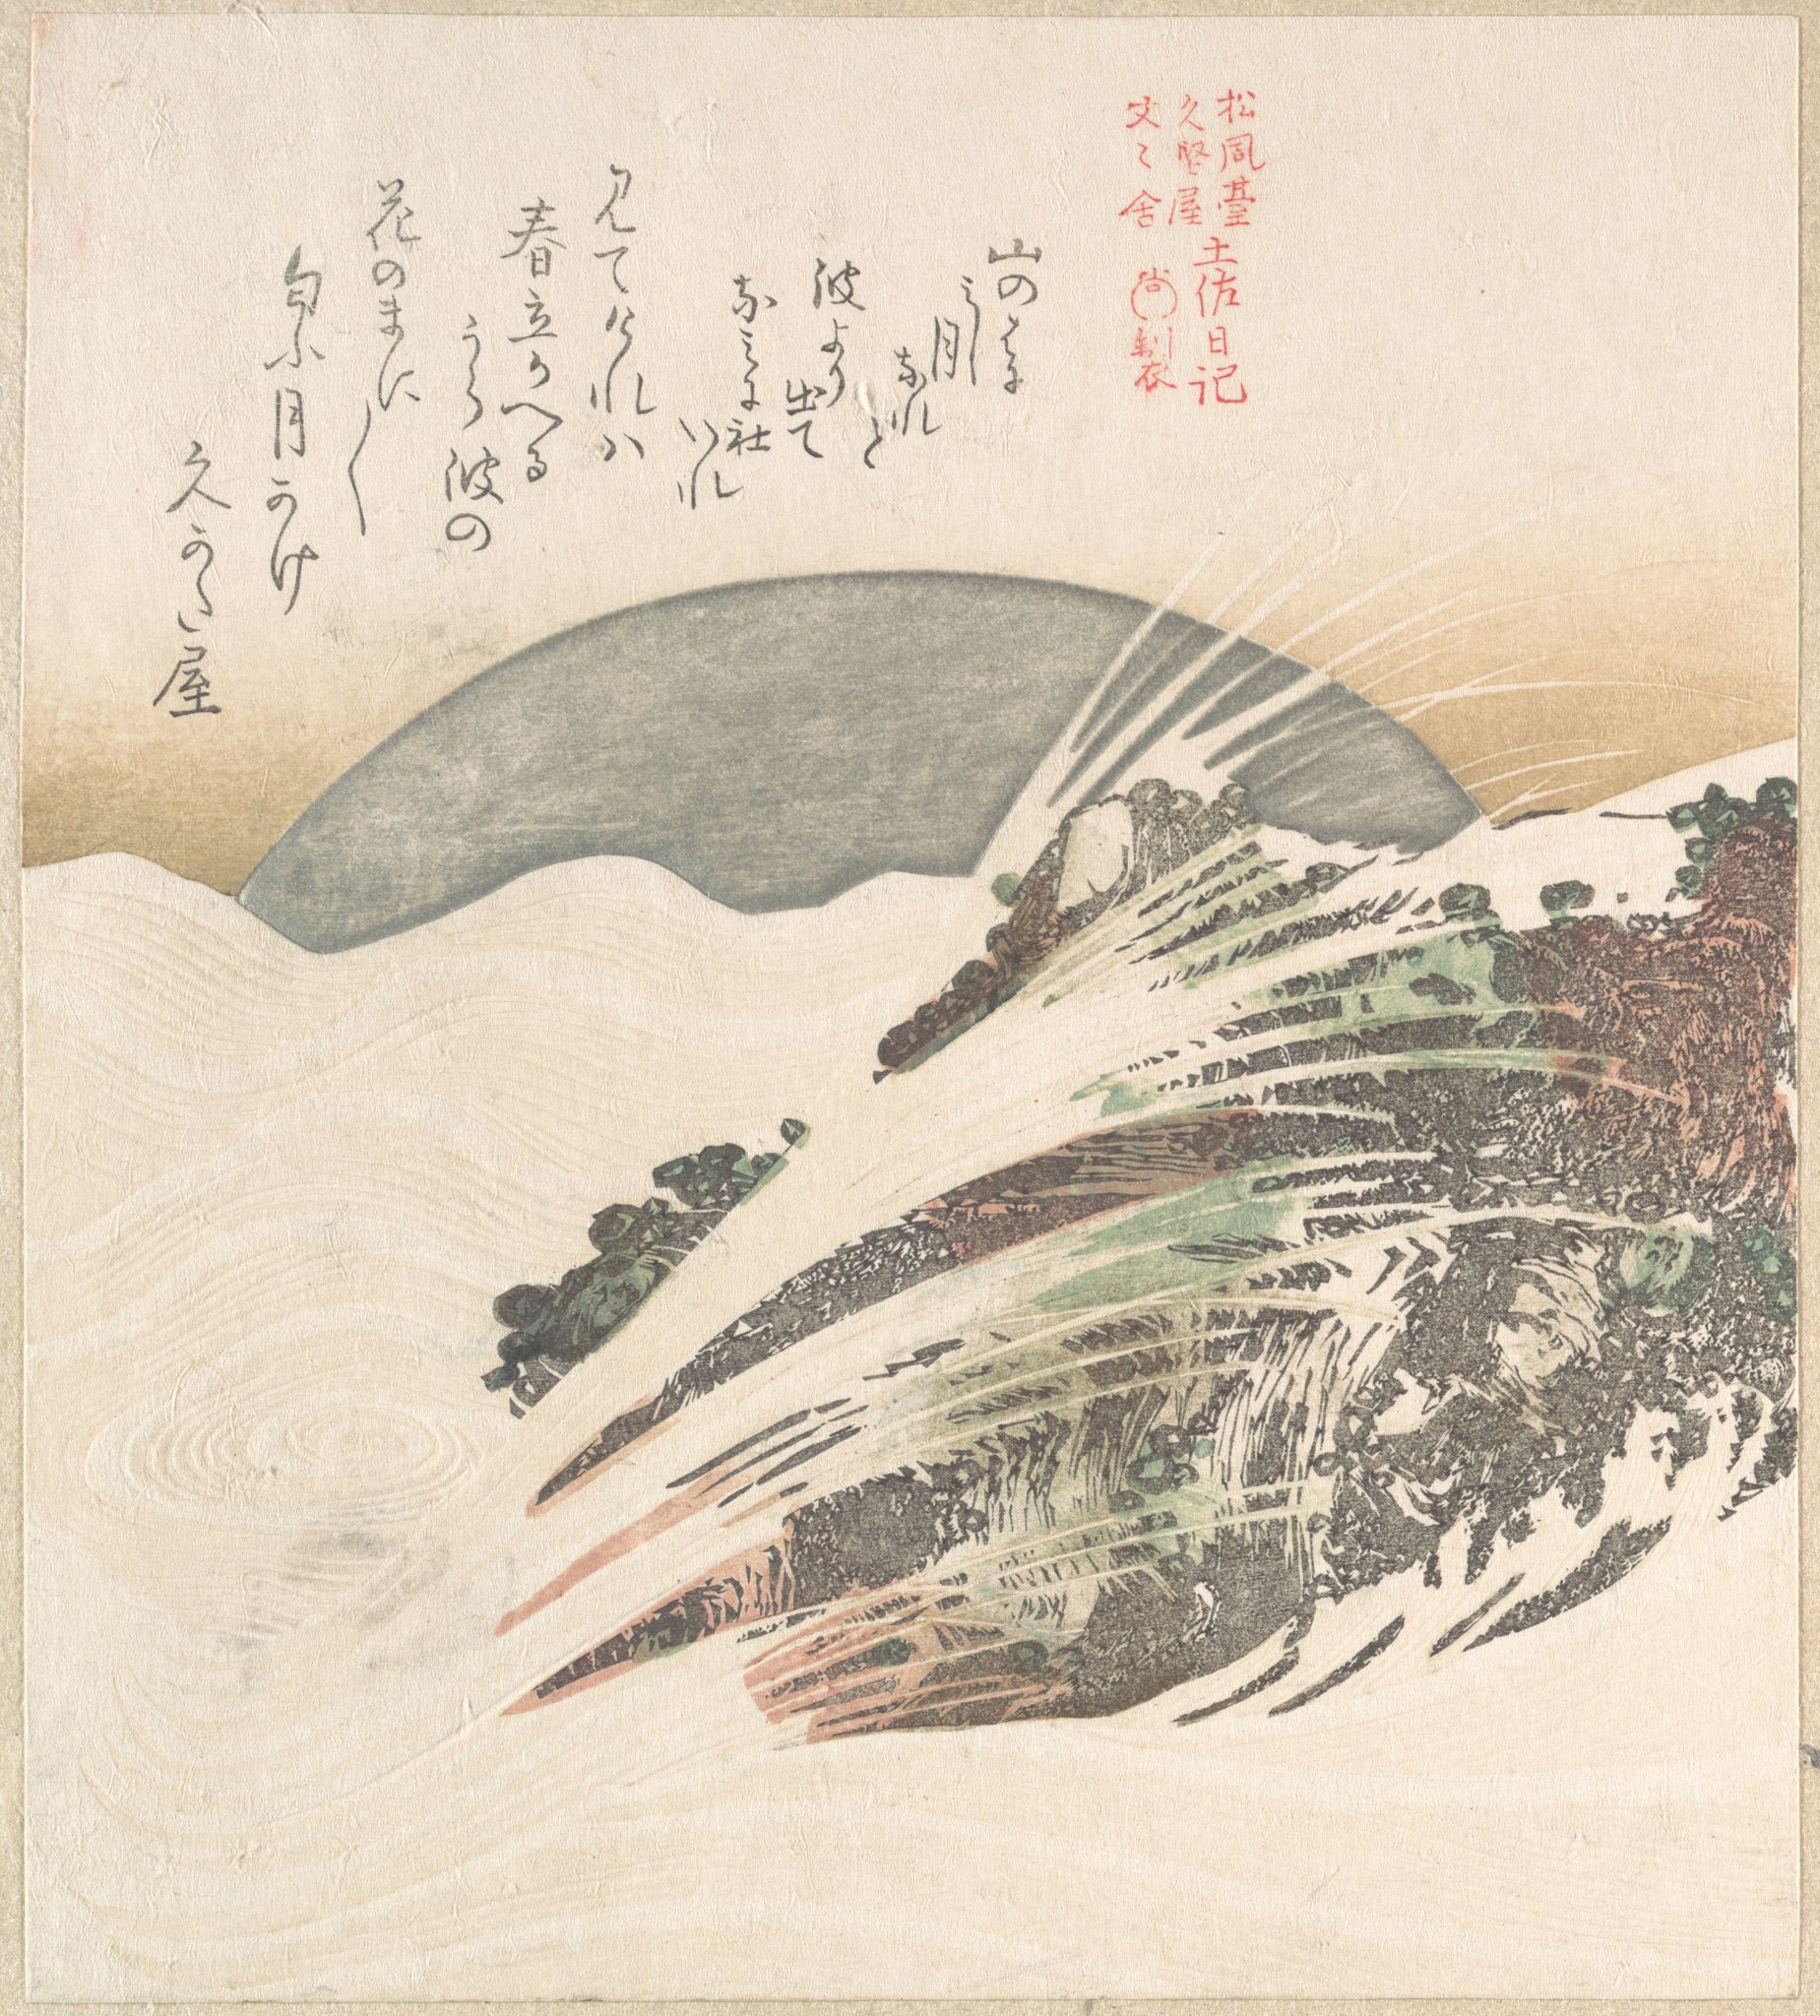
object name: print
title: Setting Moon on Waves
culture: japanese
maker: kubo shunman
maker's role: artist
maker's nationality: japanese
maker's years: 1757-1820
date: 1801-1900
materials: ink, paper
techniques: surimono, woodblock print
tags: moon,seascapes,waves